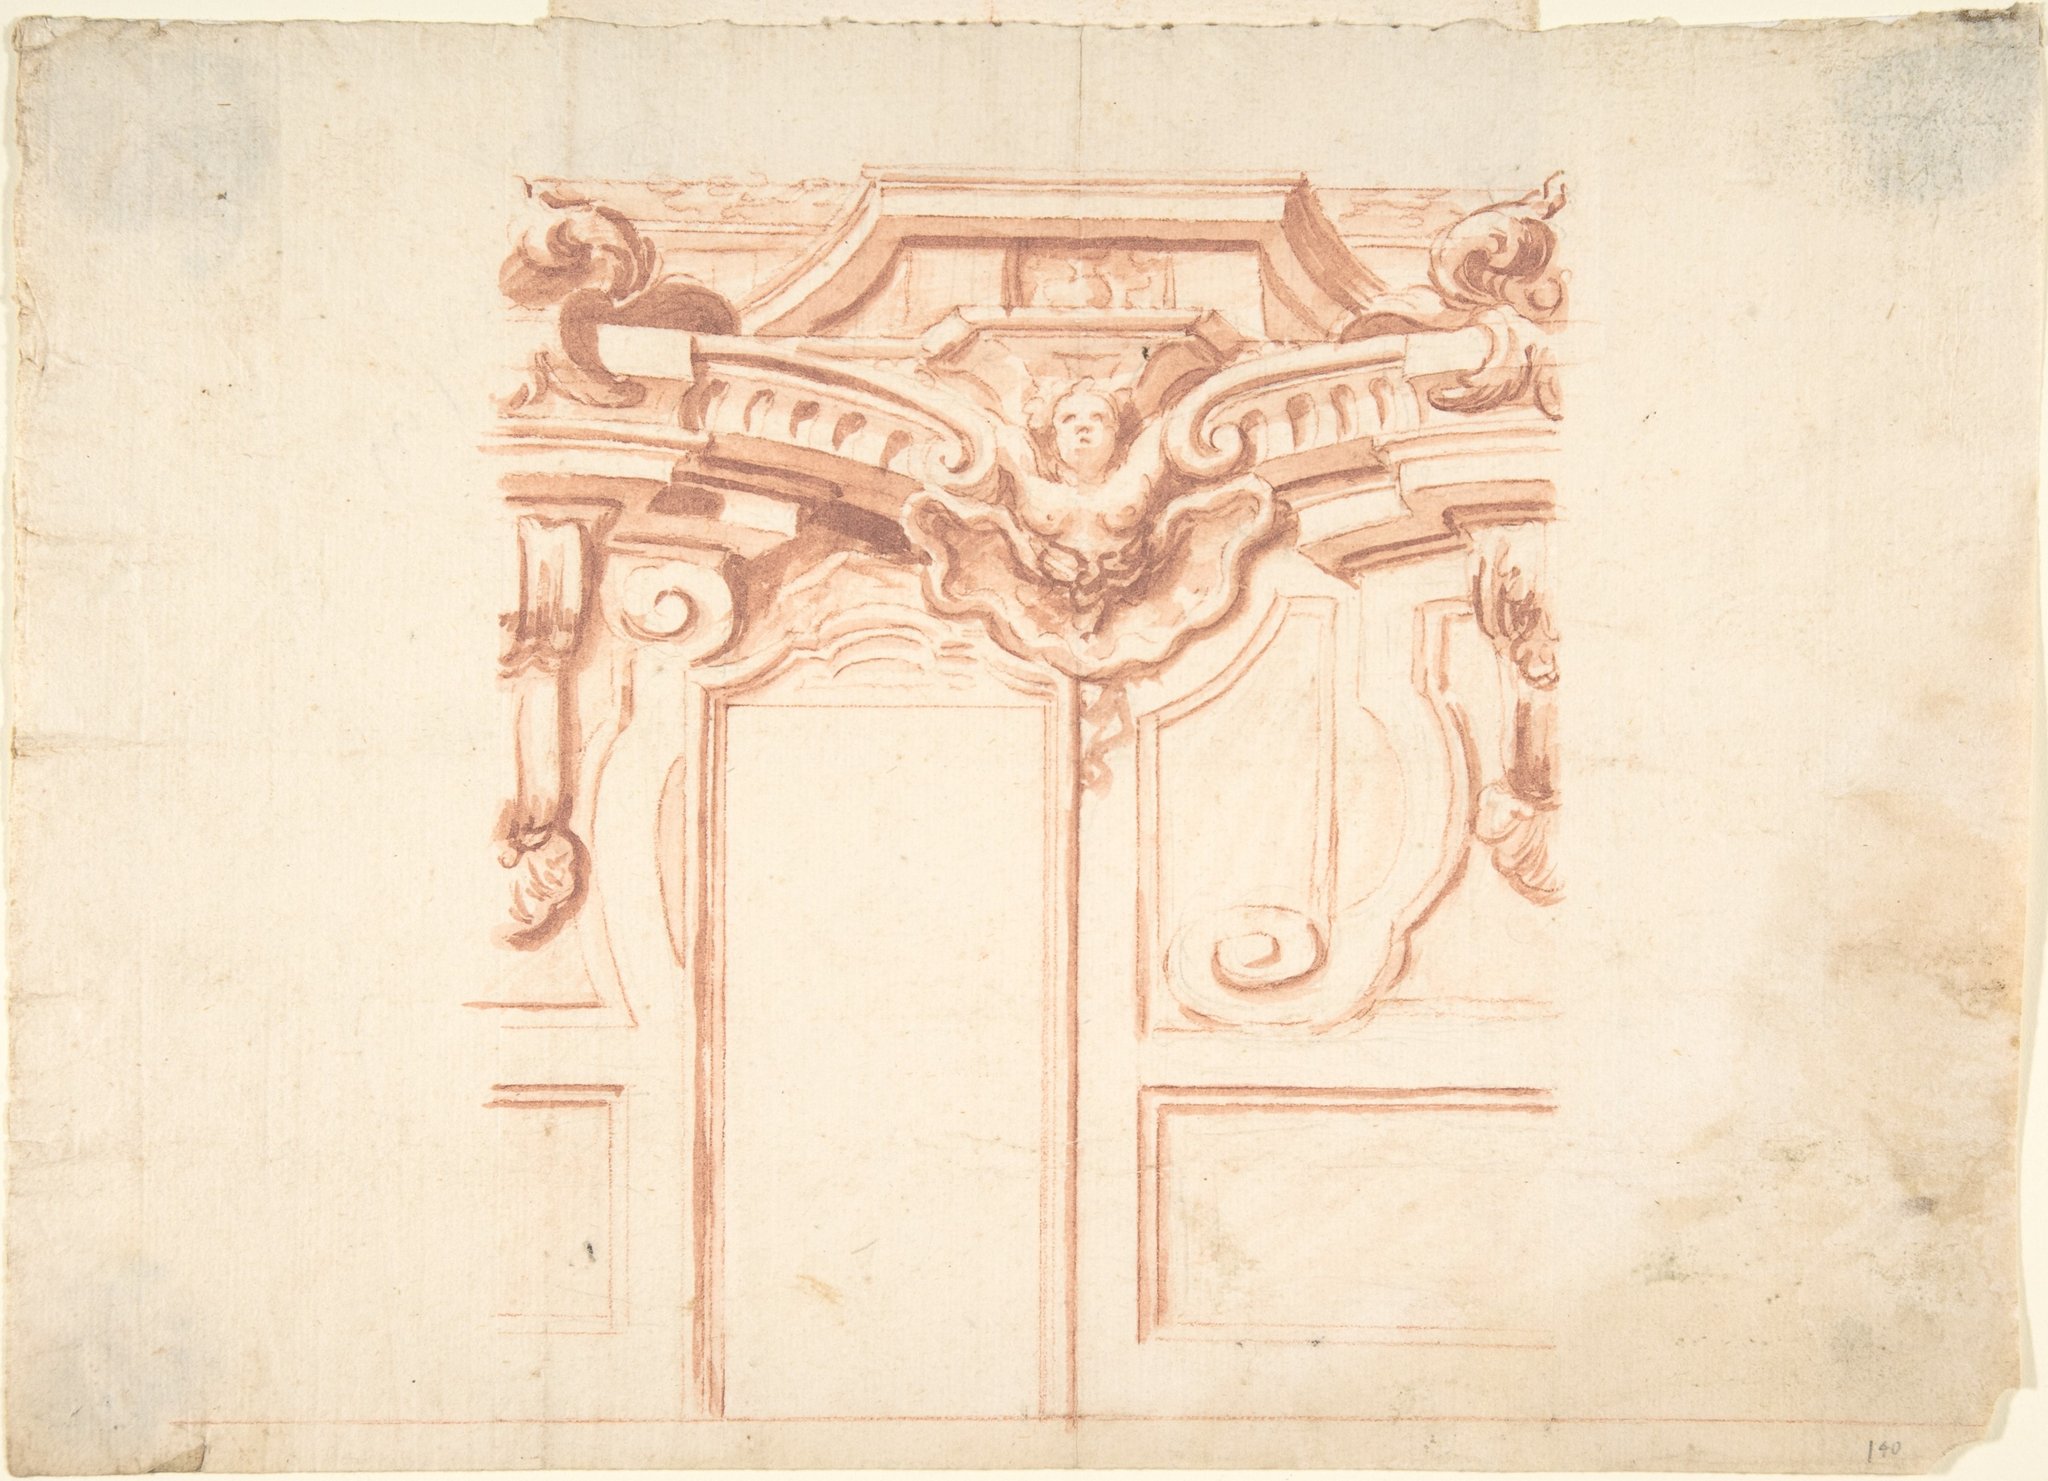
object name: drawing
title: Design for the Decorative Scheme of a Wall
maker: anonymous, italian, piedmontese, 18th century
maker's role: artist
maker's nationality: italian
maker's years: 1700-1800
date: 1700-1740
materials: chalk, drawing material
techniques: brush, wash